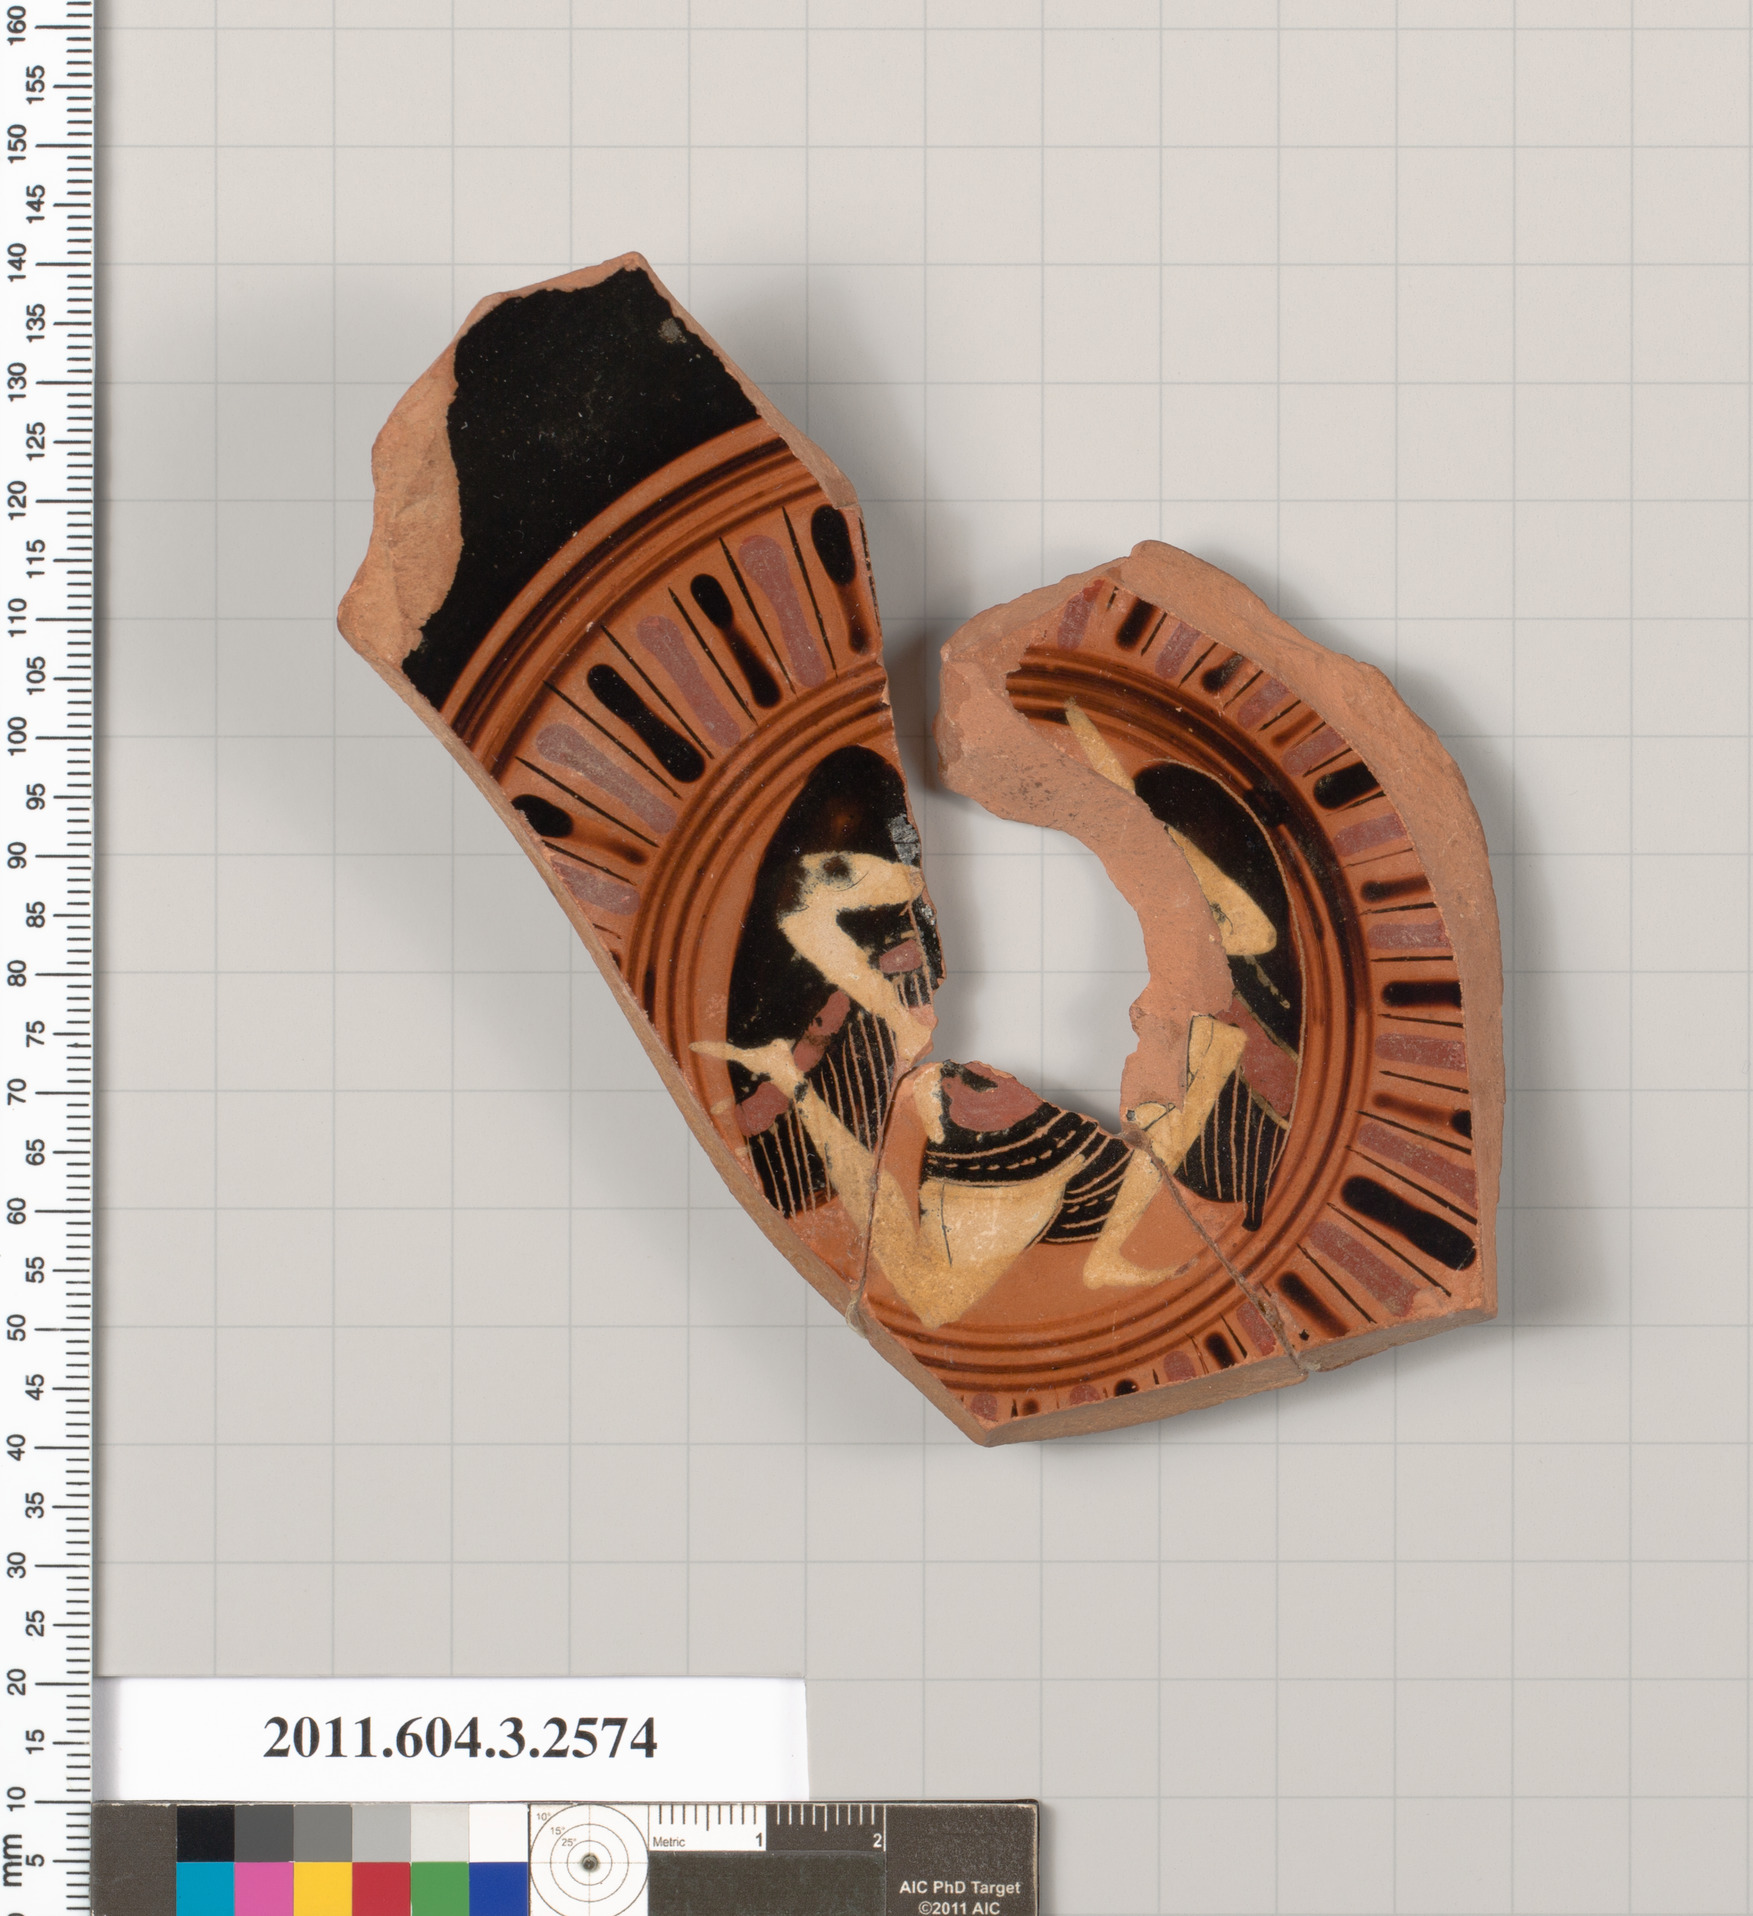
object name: kylix fragment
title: Terracotta fragment of a Little Master cup (drinking cup)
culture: greek, attic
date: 560-530 BCE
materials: terracotta